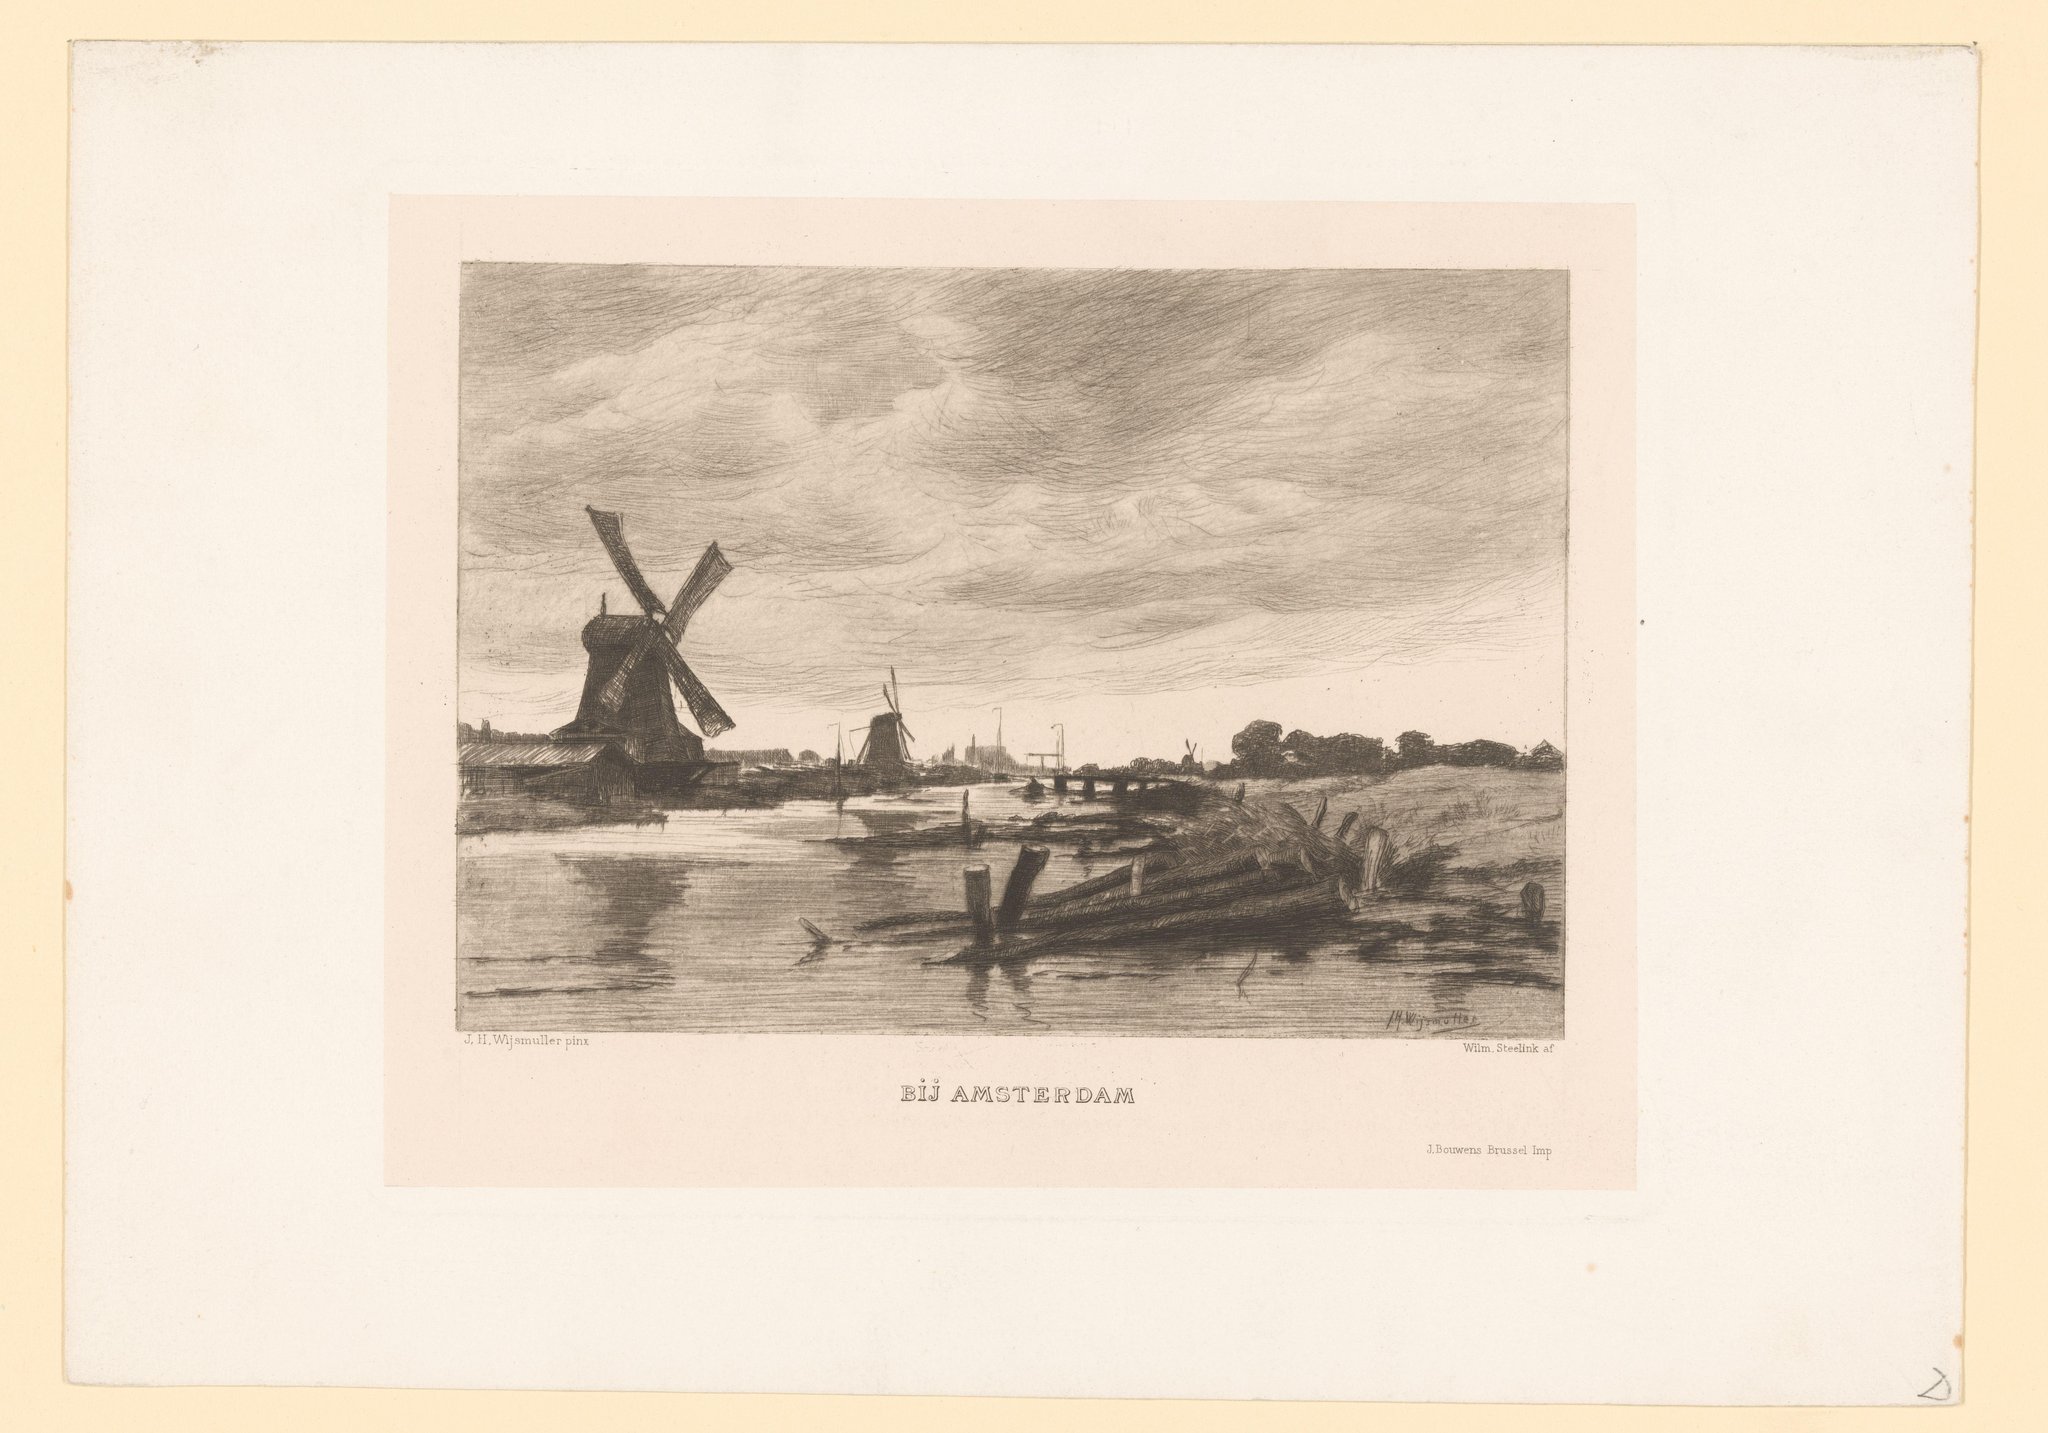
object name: print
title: Bij Amsterdam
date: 1888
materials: paper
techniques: etching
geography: brussels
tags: windmill in landscape, amsterdam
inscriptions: collector's mark: Lugt 2233